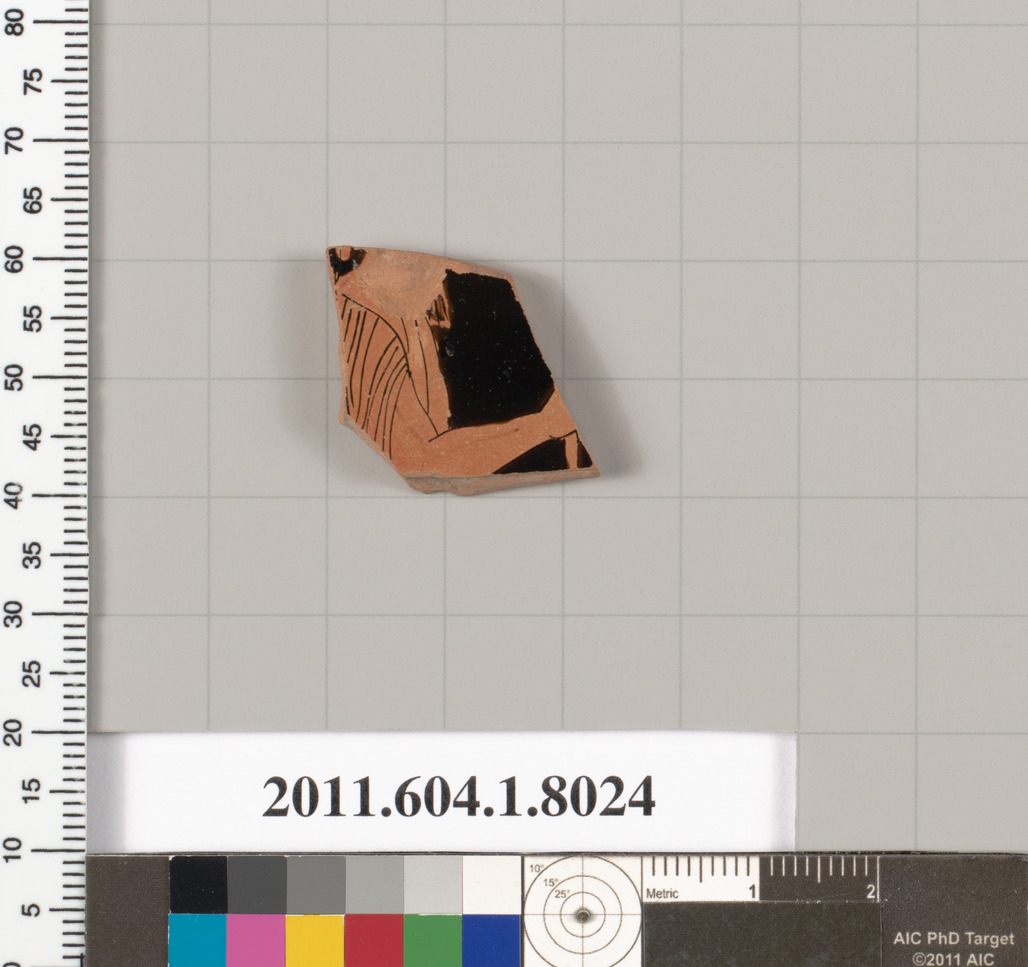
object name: kylix fragment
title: Terracotta fragment of a kylix (drinking cup)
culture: greek, attic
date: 500-480 BCE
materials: terracotta